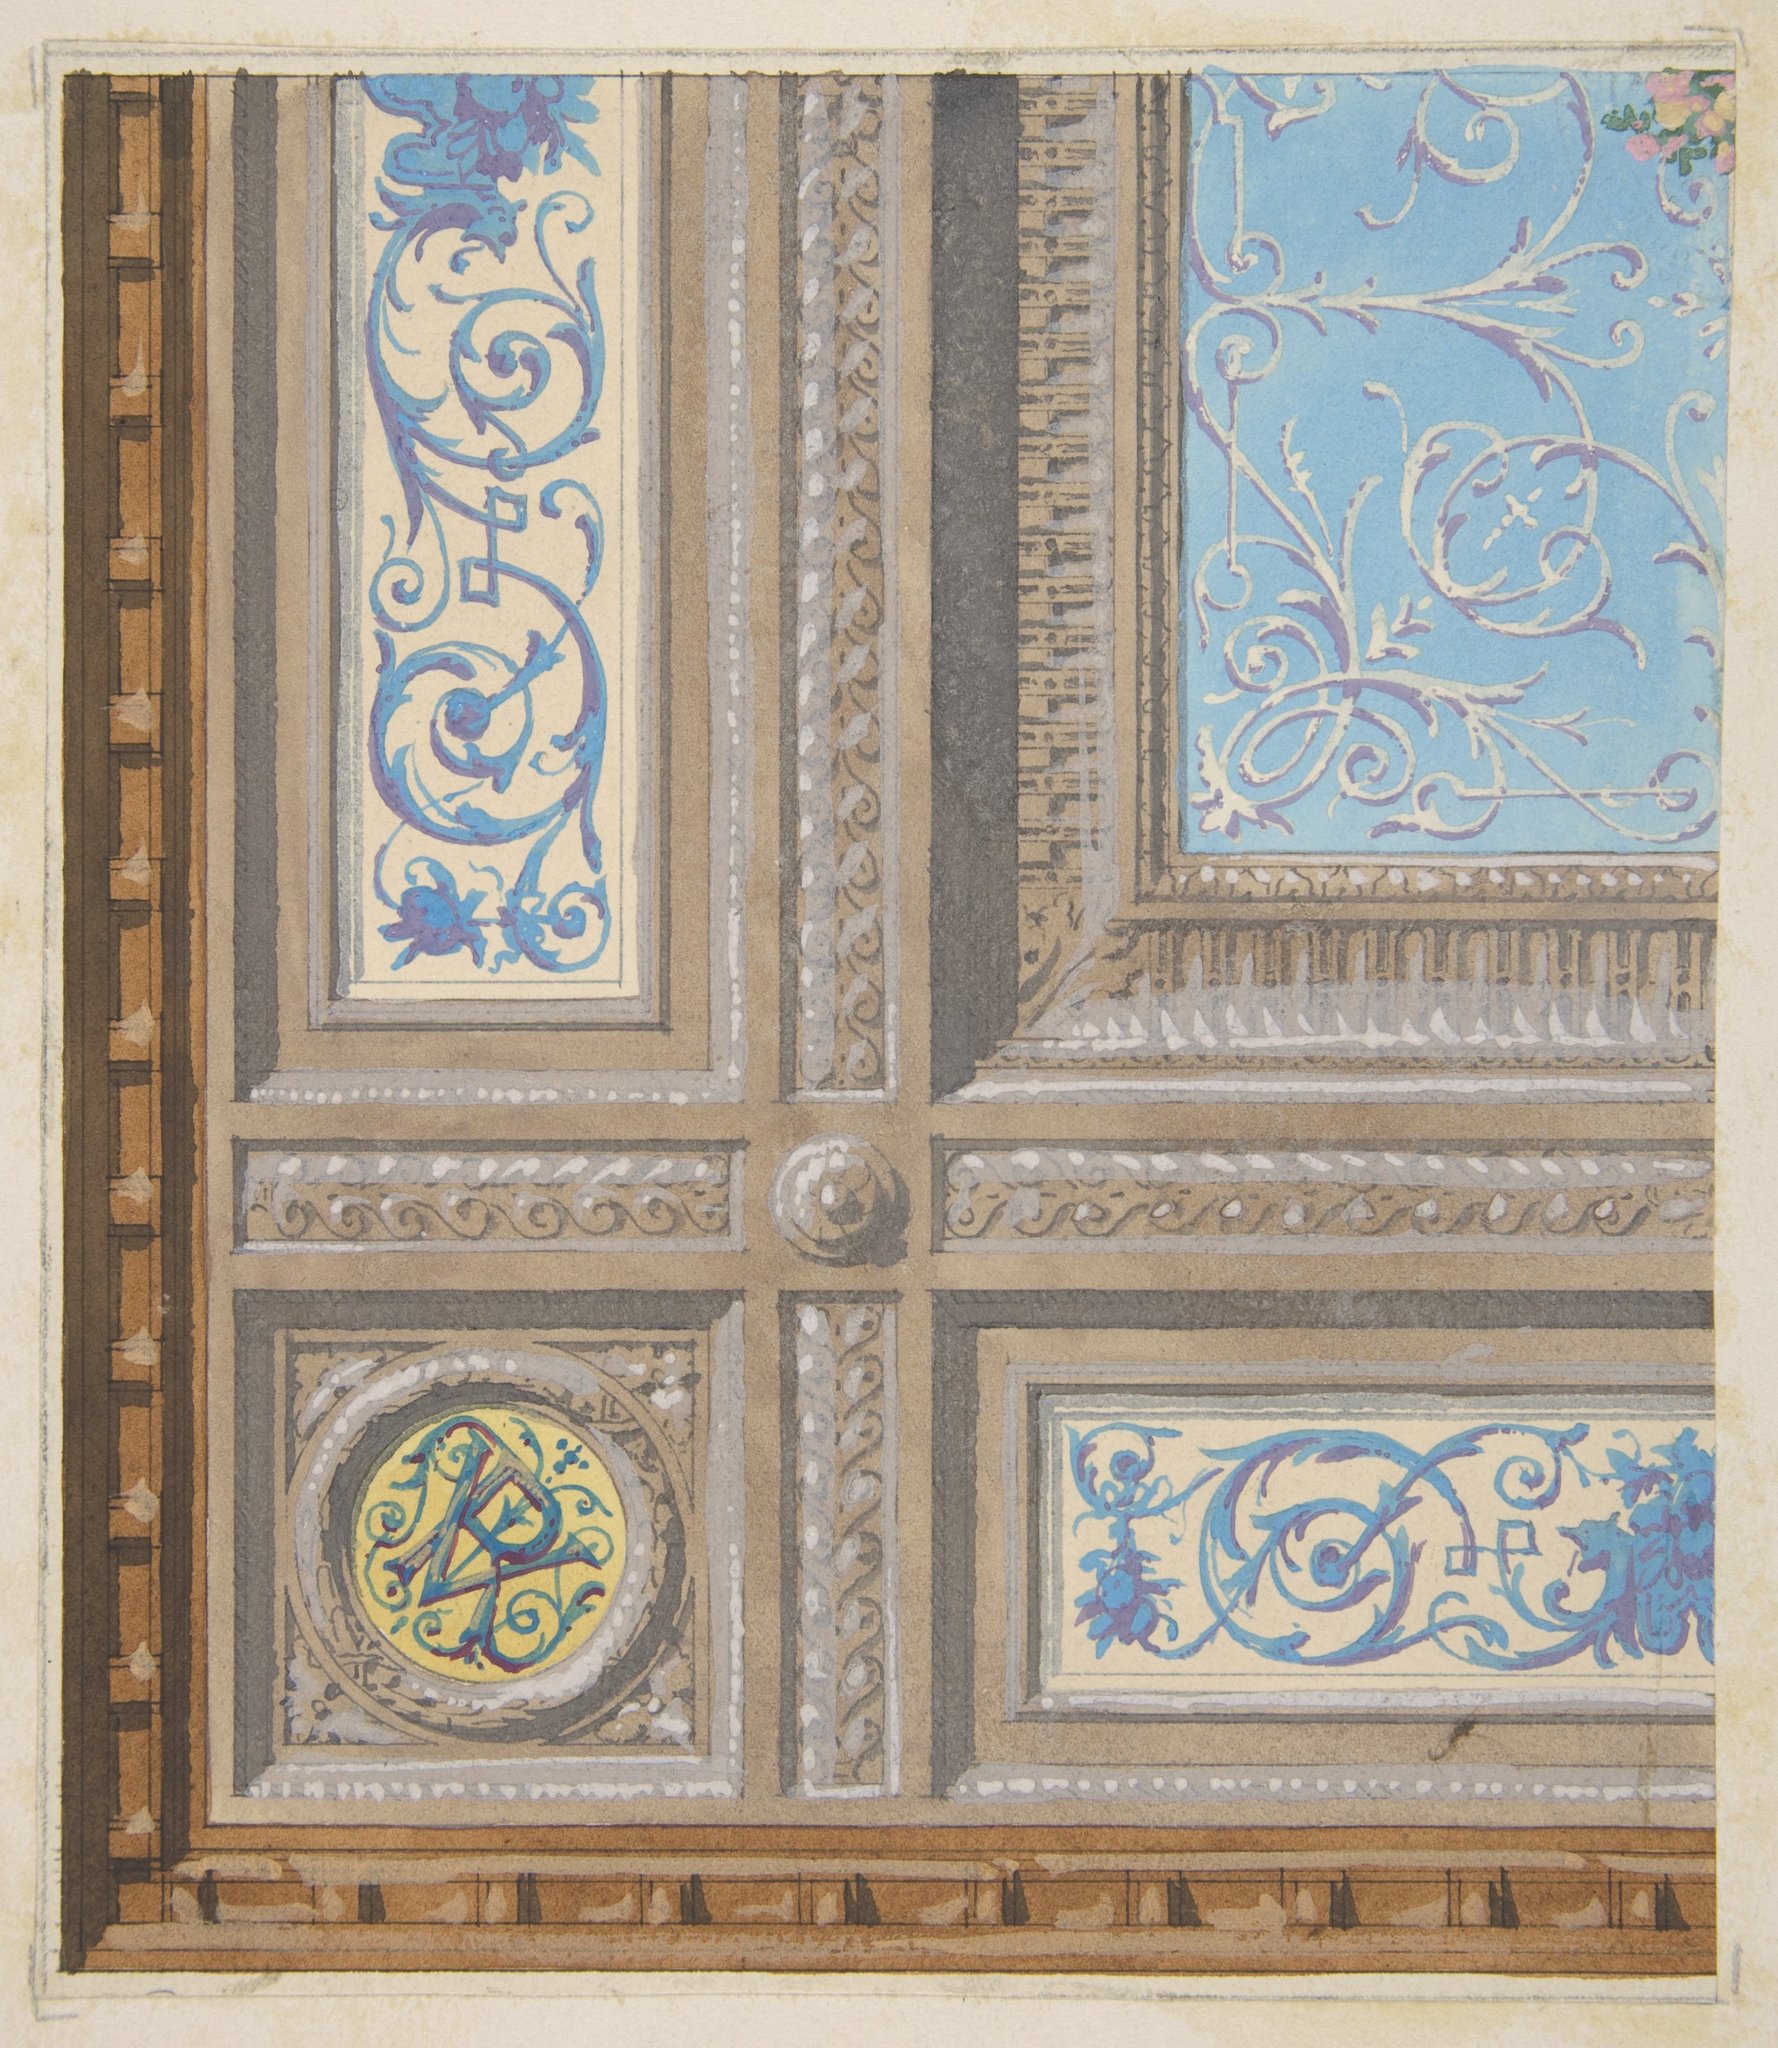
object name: drawing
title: Design for the painted decoration of a coffered ceiling with initials: VR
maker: jules-edmond-charles lachaise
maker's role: artist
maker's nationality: french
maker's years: 1897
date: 1830-1897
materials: gouache, ink, watercolor, paper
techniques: pen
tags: ceilings